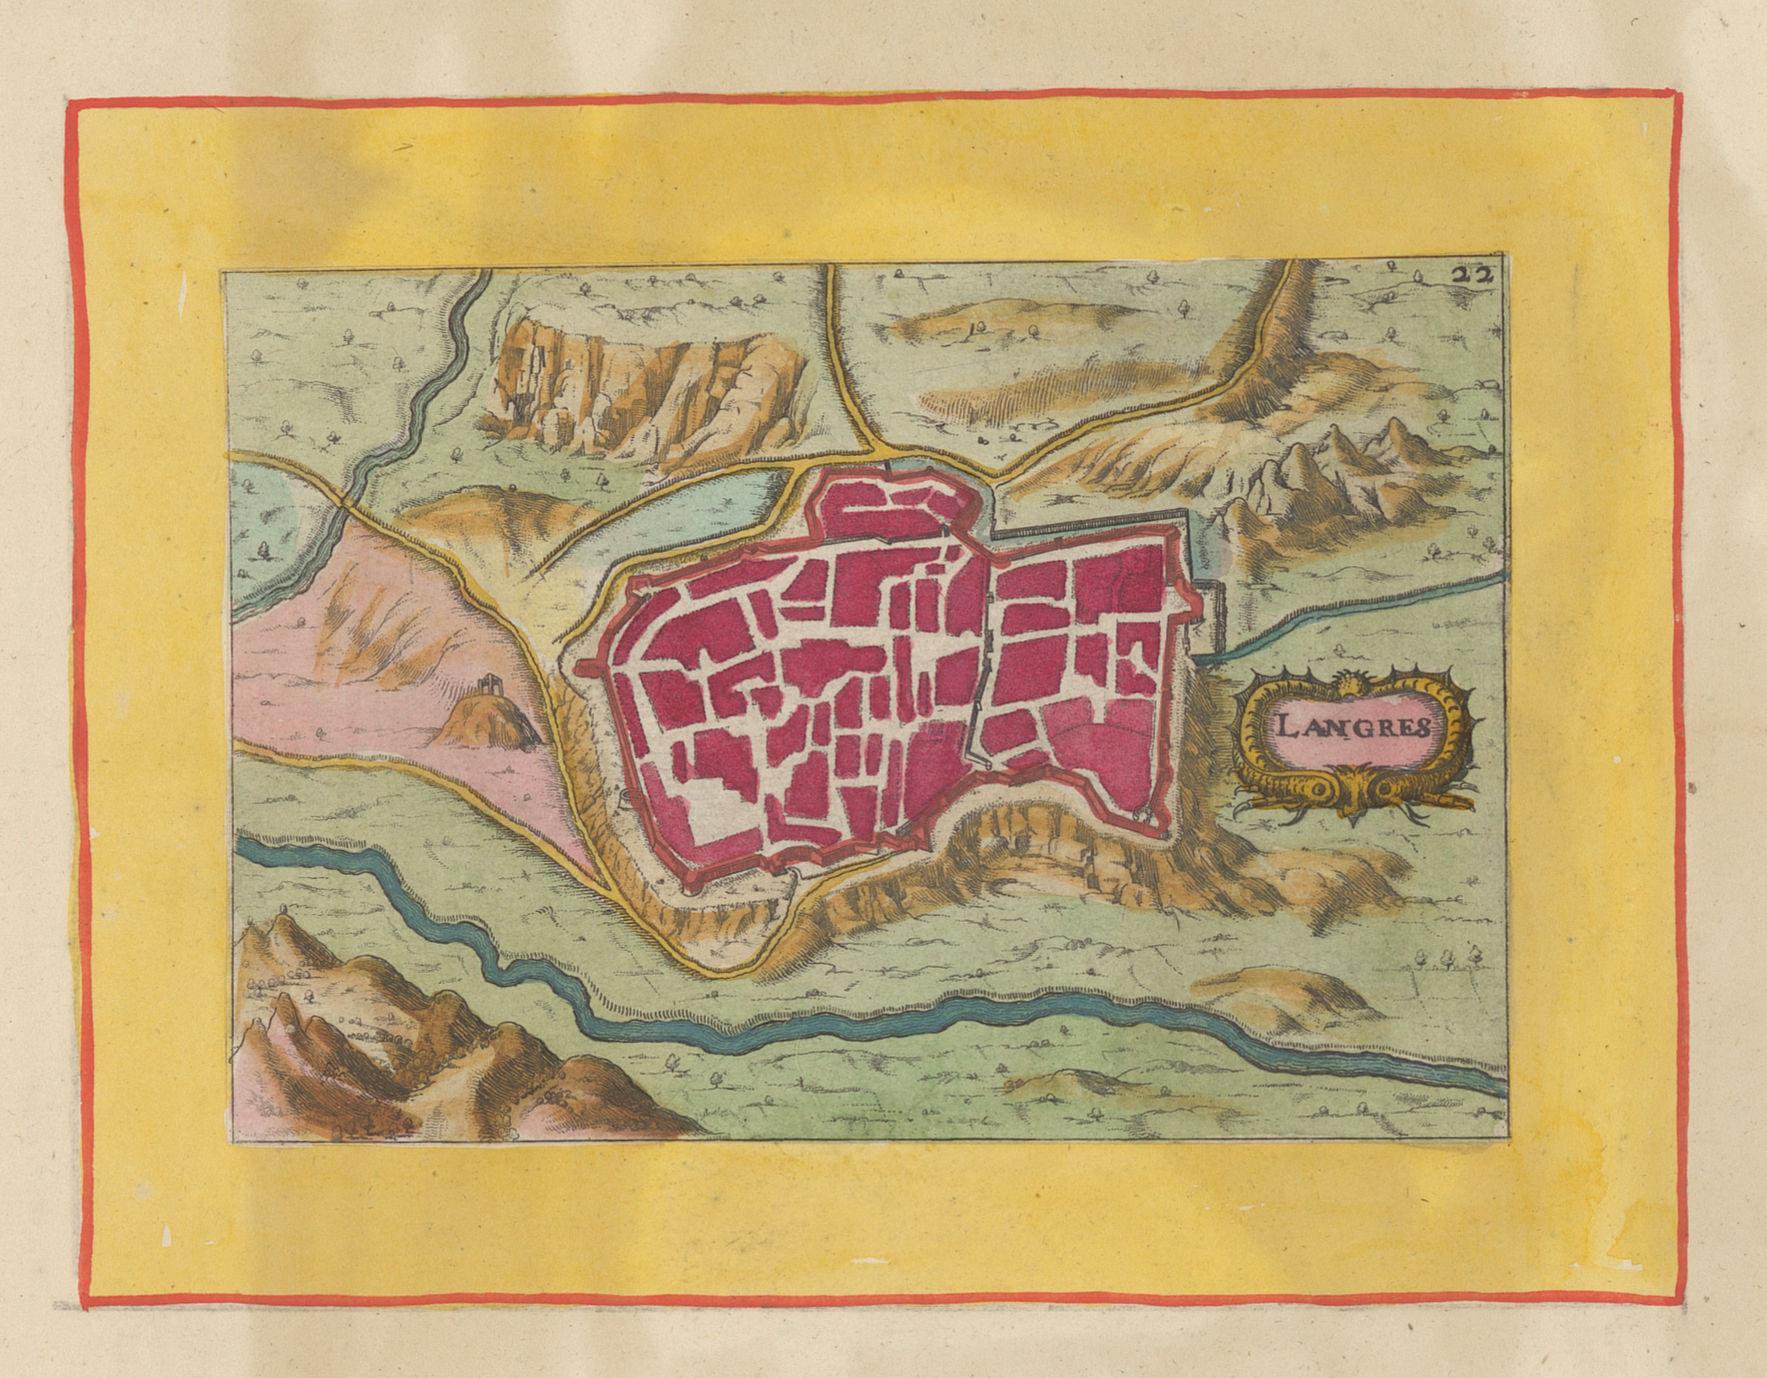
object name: area plan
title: Langres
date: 1638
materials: paper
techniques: engraving, hand coloring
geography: the hague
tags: maps of cities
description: Prent uit: Tassin, Christophe. Les plans et profils de toutes les principales villes et lieux considérables de France (...). Parijs: Michel van Lochom, 1638, plattegrond 22 uit het deel 'Champagne'.